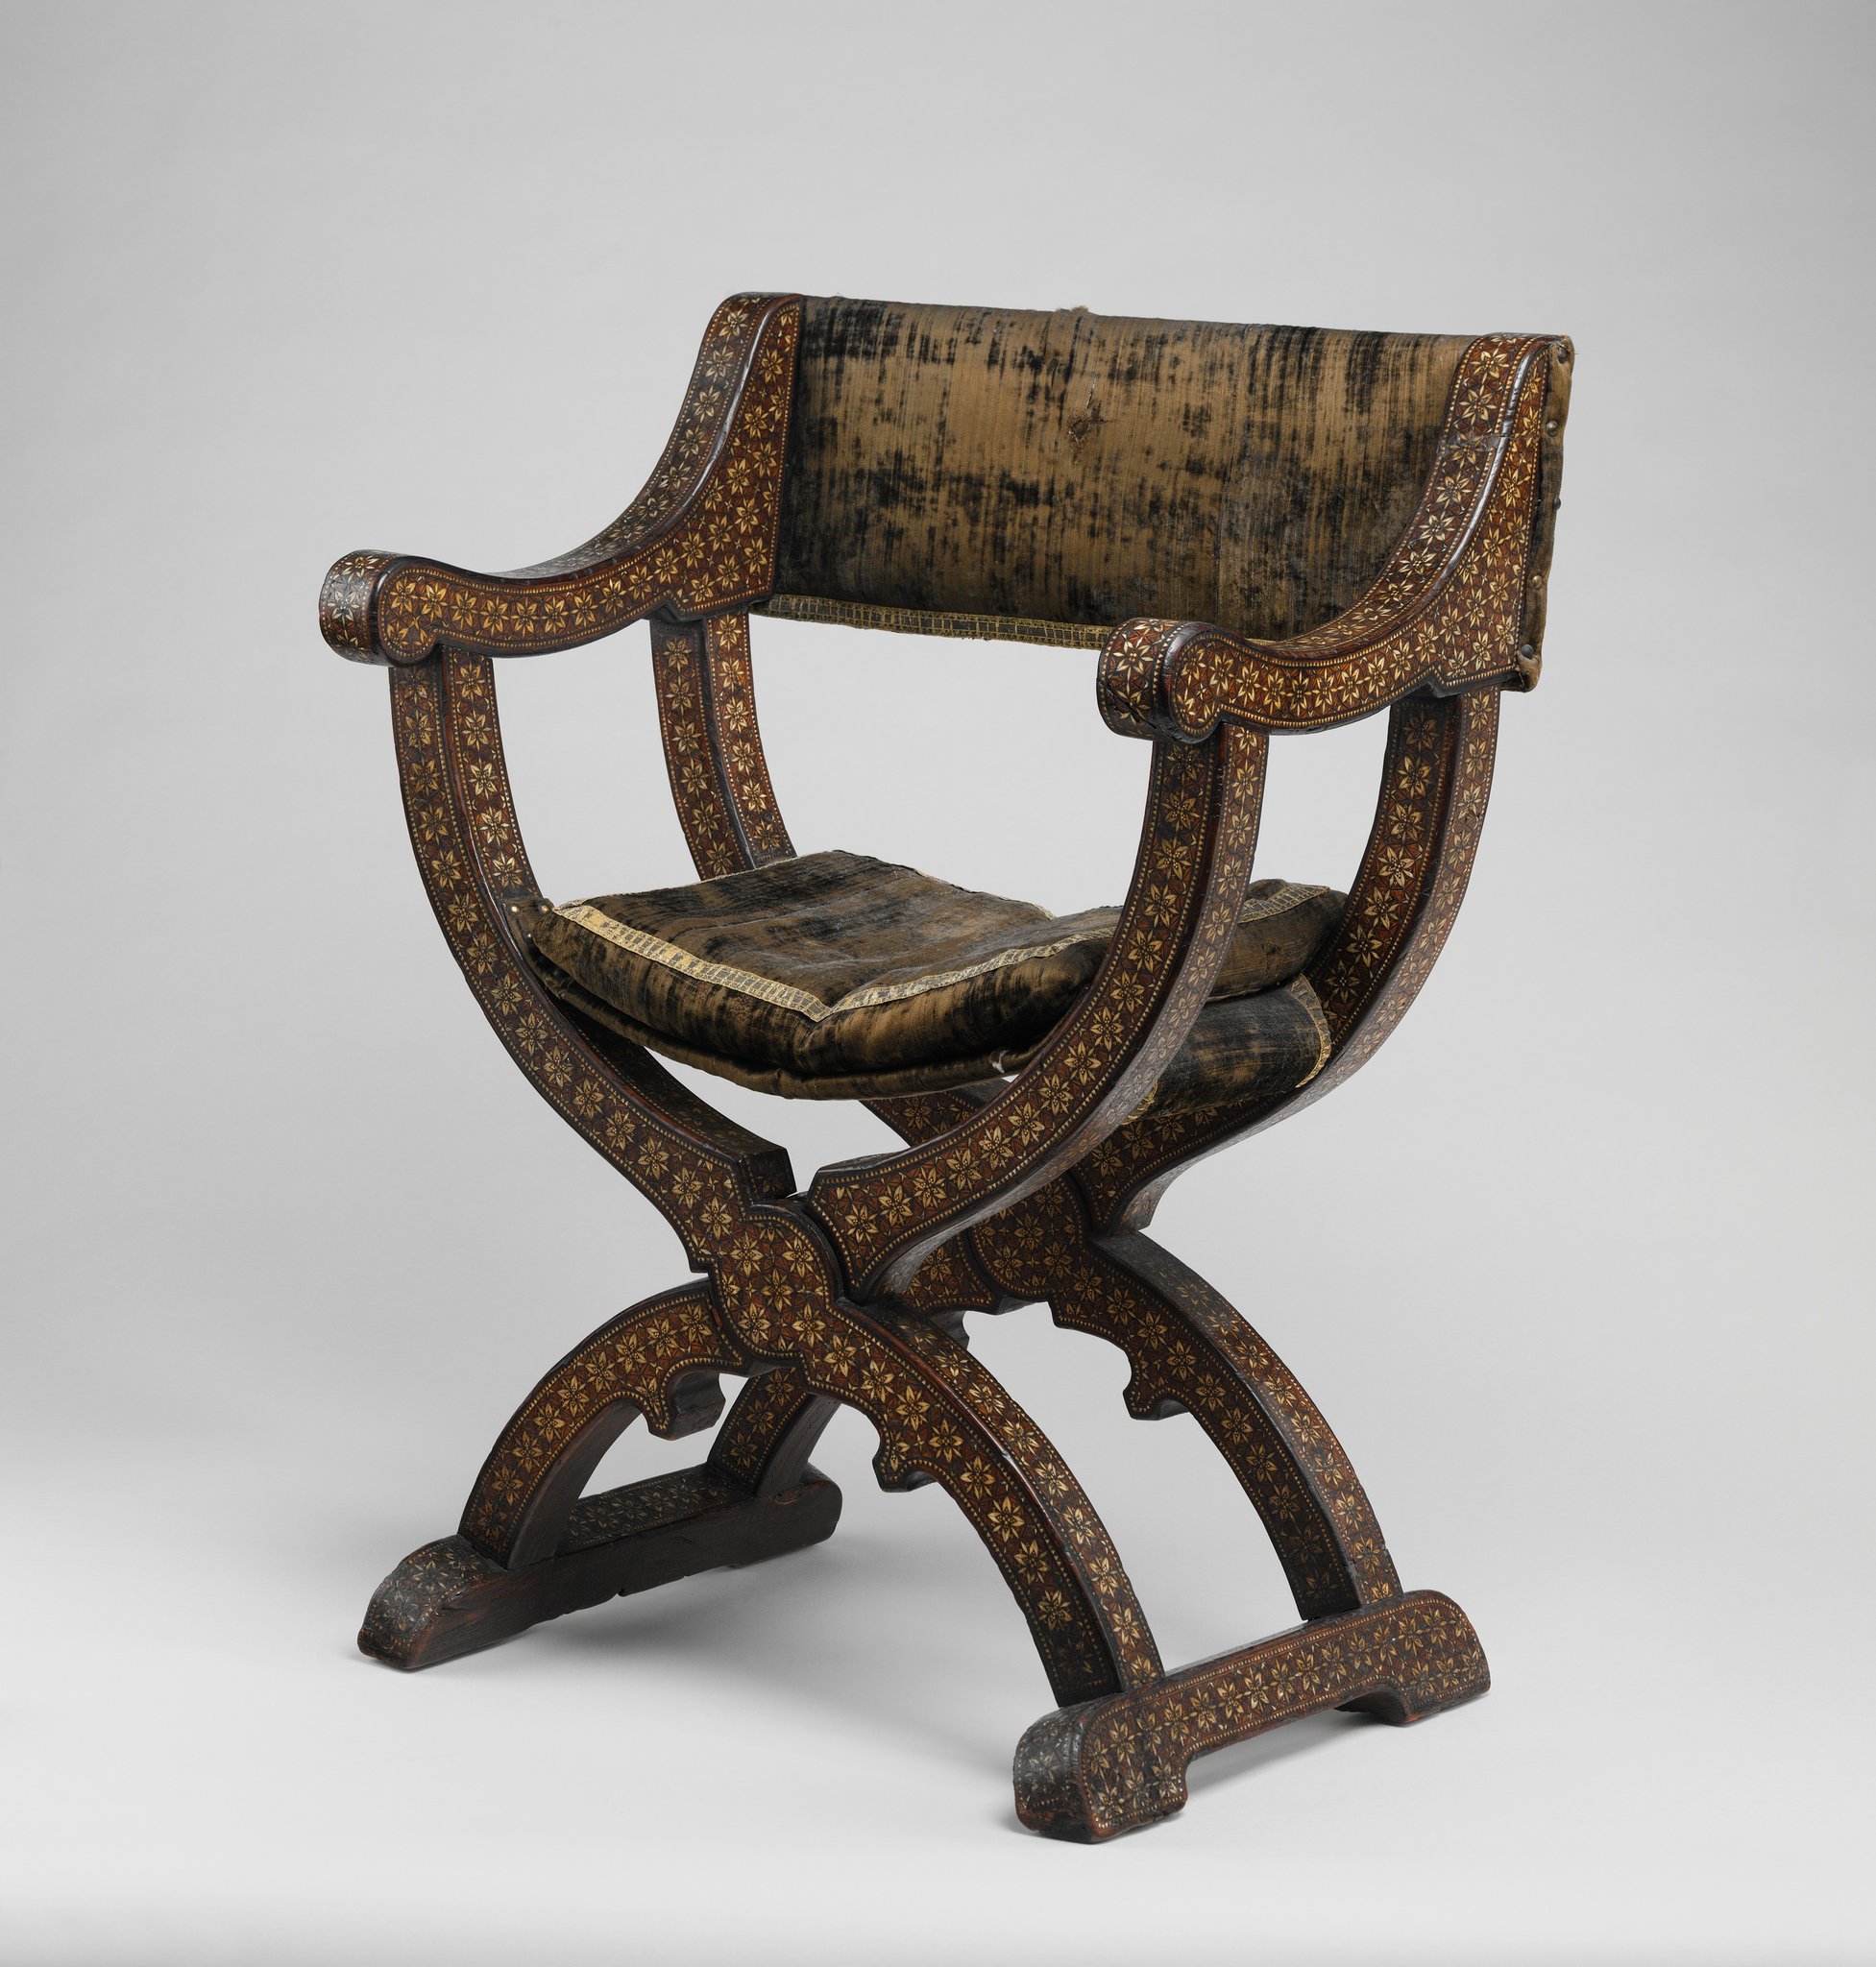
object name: hip joint armchair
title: Hip-joint armchair (sillón de cadera or jamuga)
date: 1480-1500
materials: bone, wood, ivory, pewter, silk, velvet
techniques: inlay, veneering